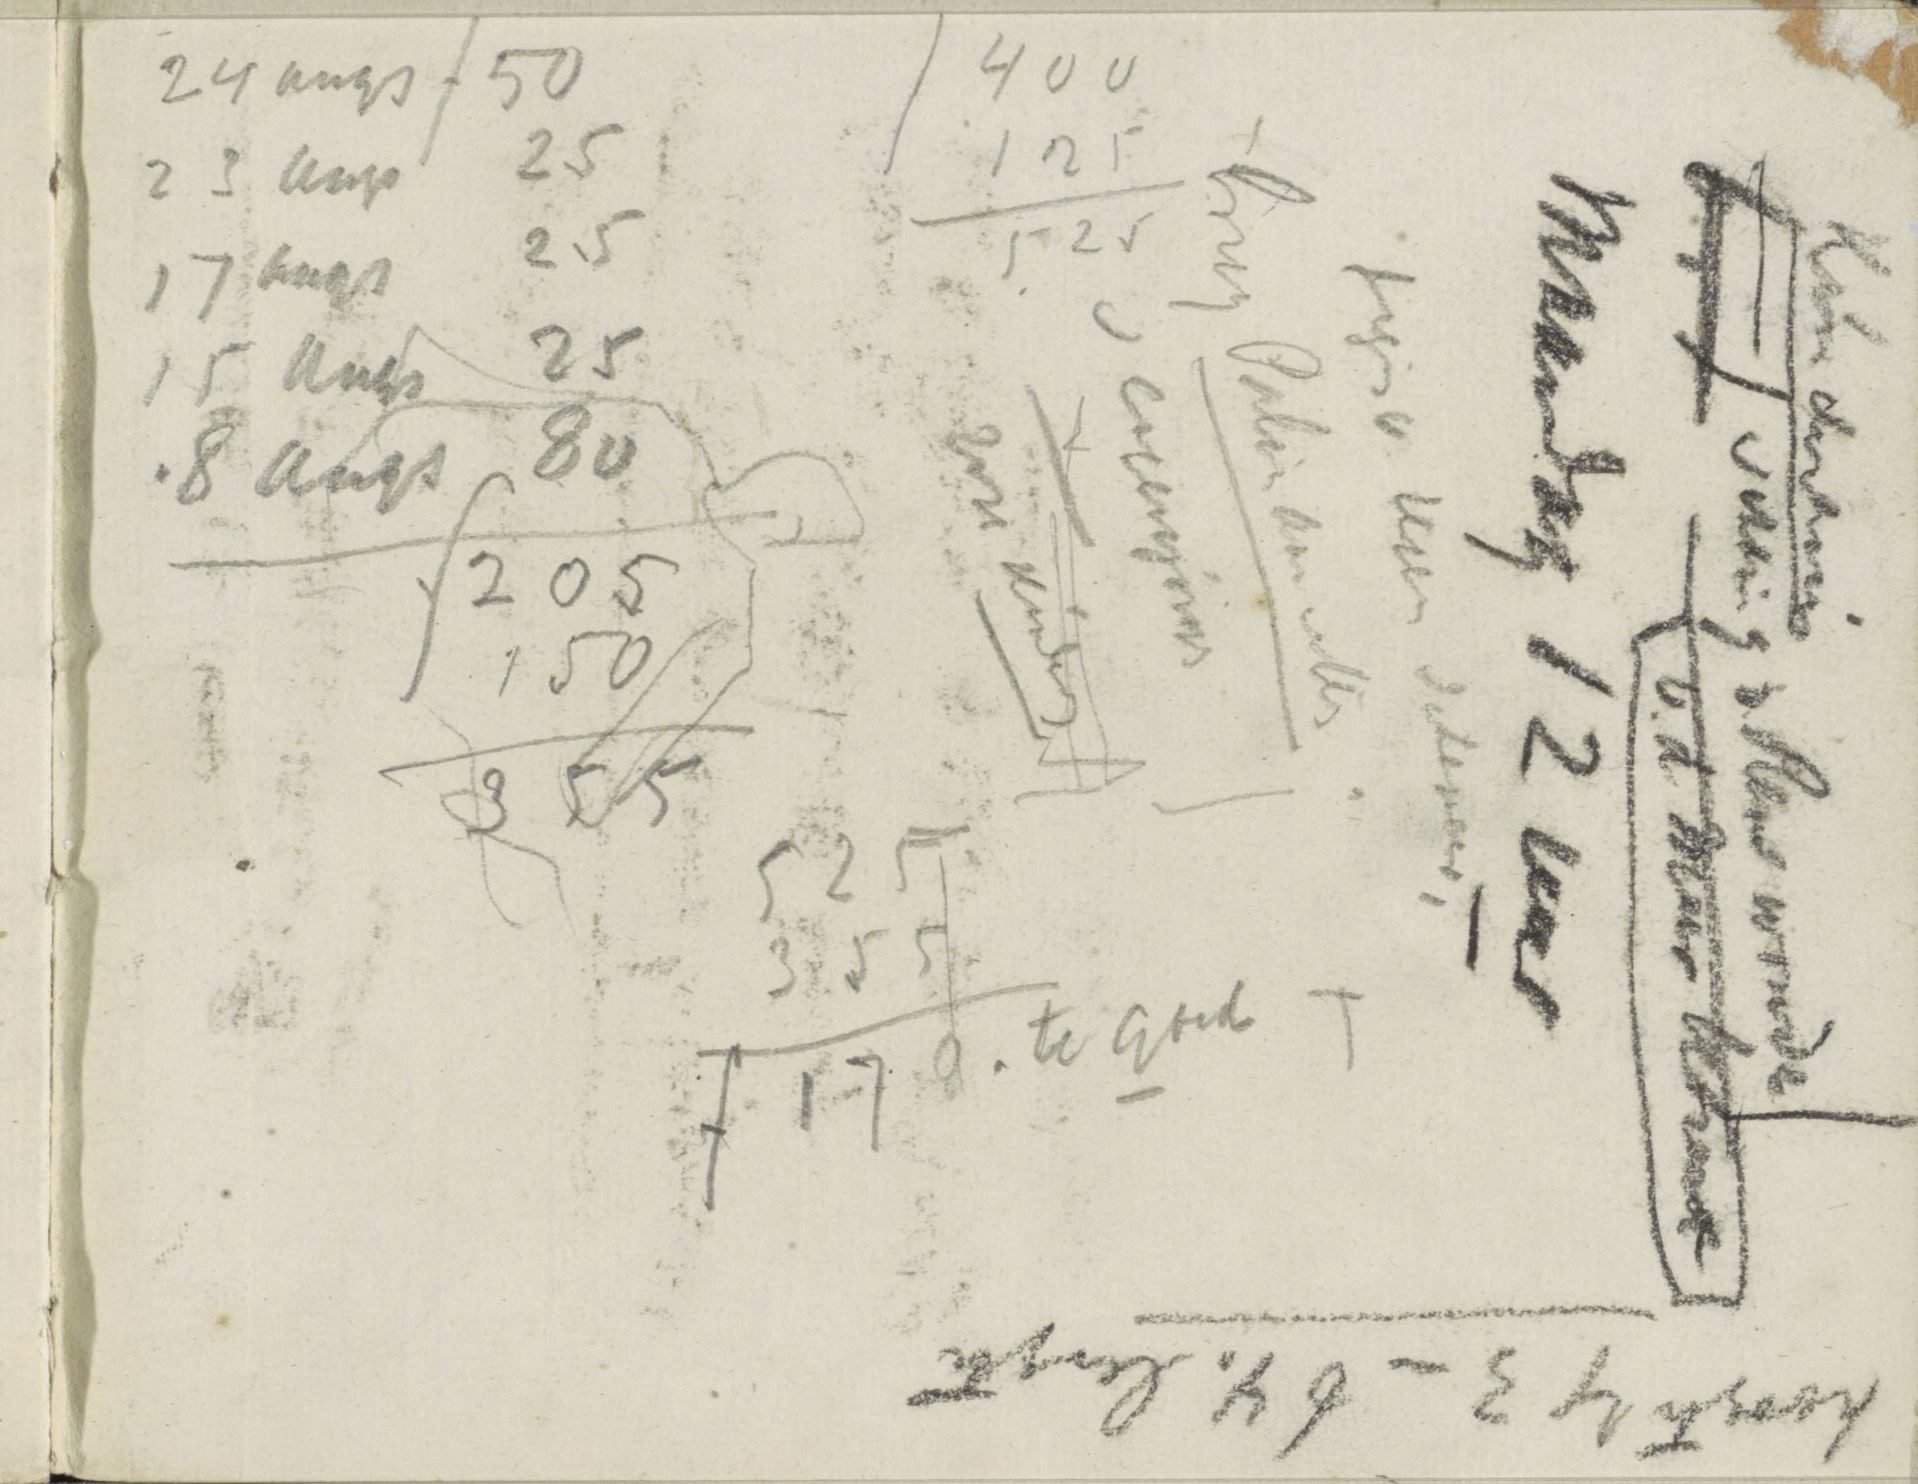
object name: sketchbook leaf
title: Annotaties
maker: george hendrik breitner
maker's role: draughtsman, painter, print maker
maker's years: 1857-1923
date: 1886-1903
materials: chalk, paper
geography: amsterdam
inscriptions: annotation: ‘[...]’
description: Pagina 66 uit een schetsboek met 32 bladen.